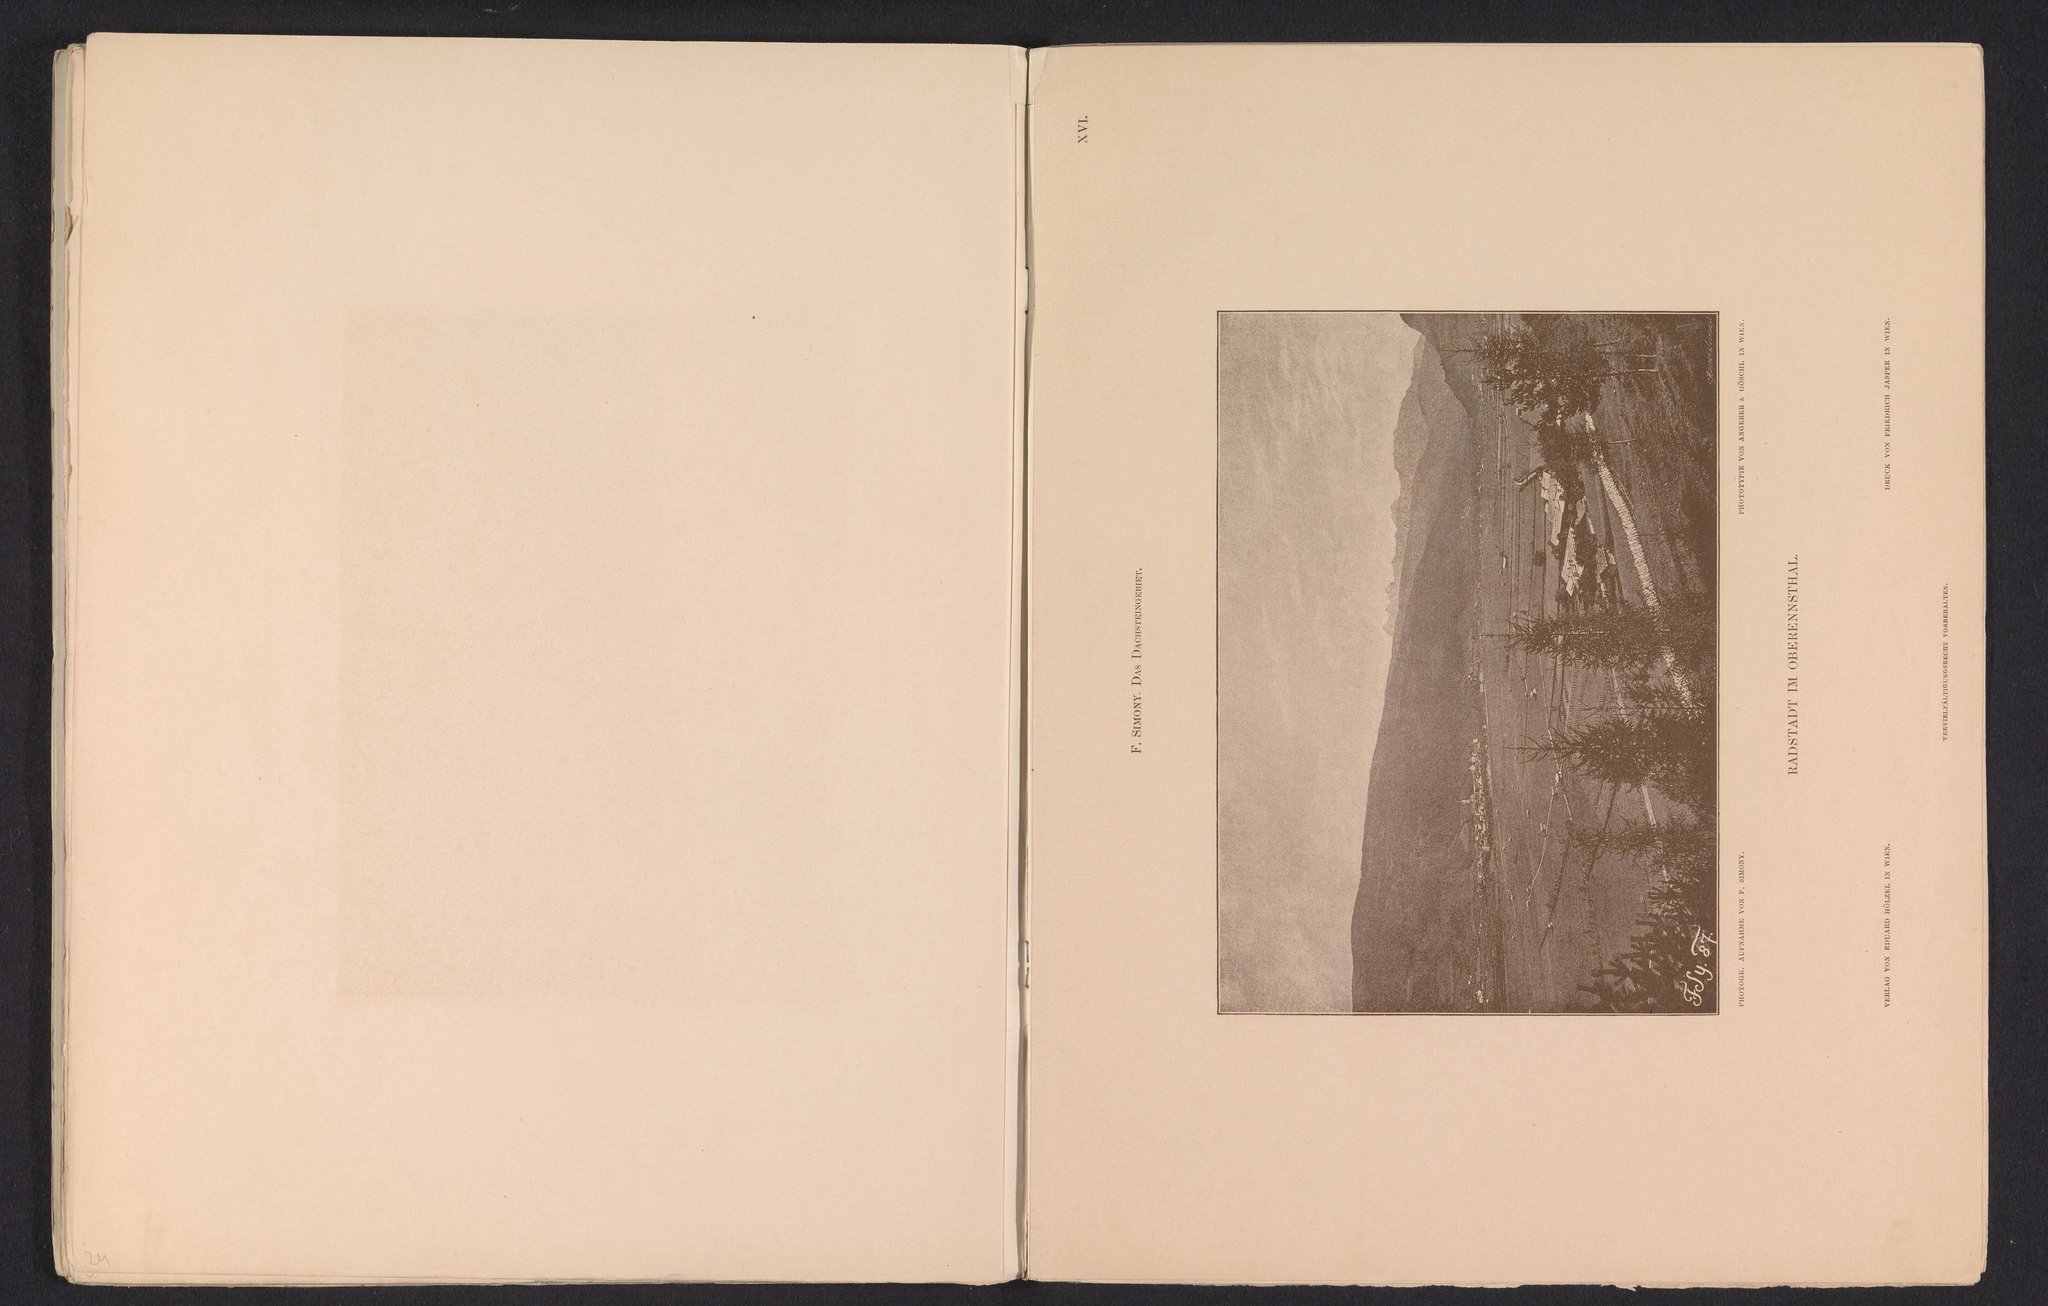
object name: photomechanical print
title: Radstadt im Oberennsthal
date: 1887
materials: paper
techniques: autotype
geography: austria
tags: city-view in general; 'veduta'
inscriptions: number: ‘XVI.’